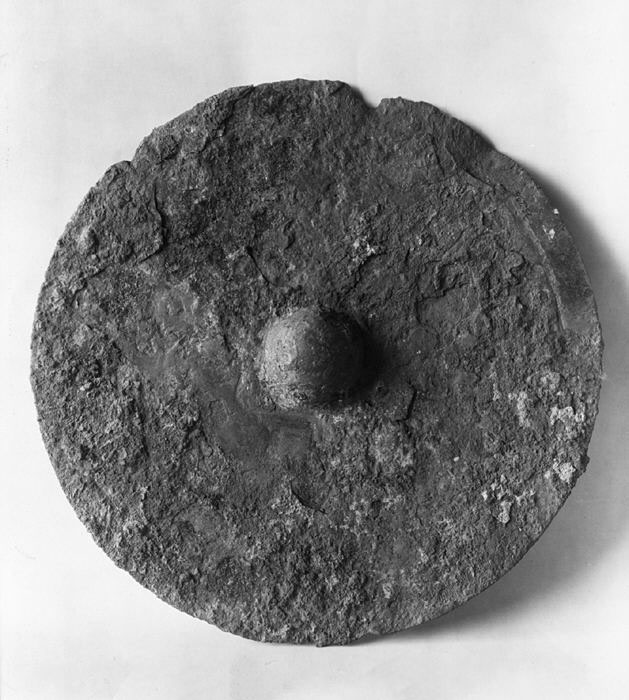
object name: mirror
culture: chinese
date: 101-300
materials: iron, silver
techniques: inlay